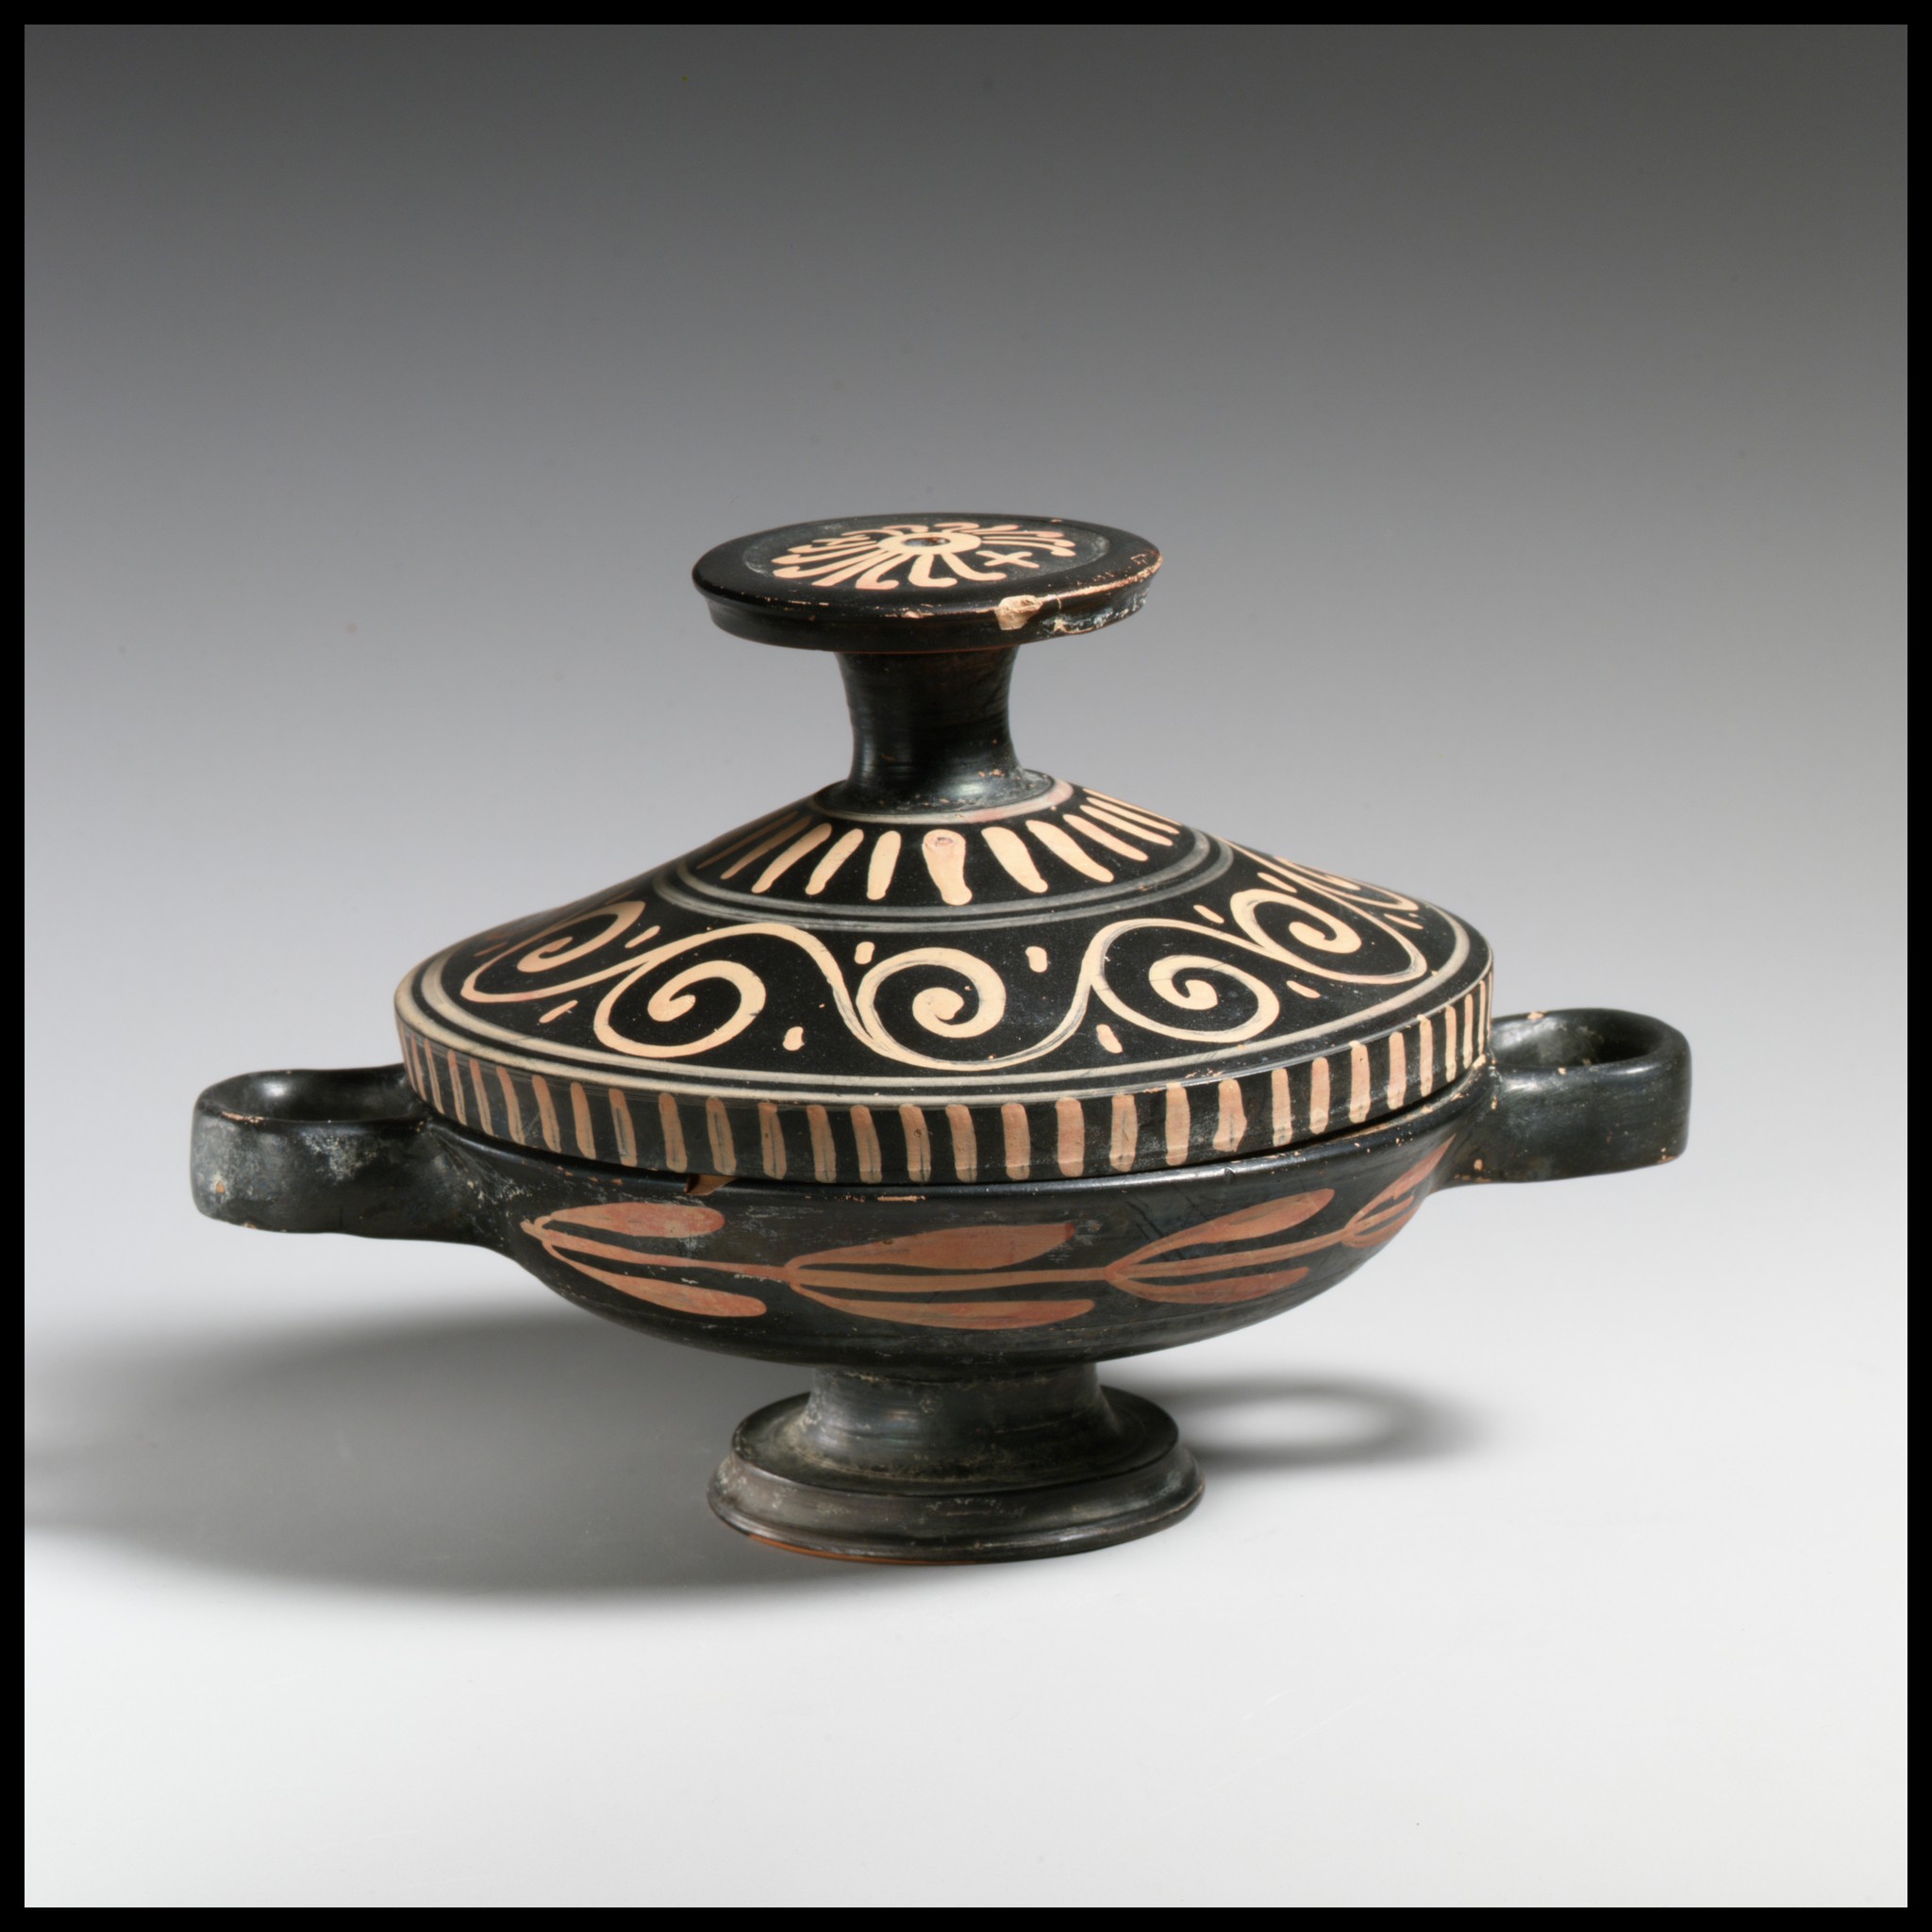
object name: lekanis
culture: greek, south italian, apulian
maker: xenon group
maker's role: artist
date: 400-301 BCE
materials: terracotta